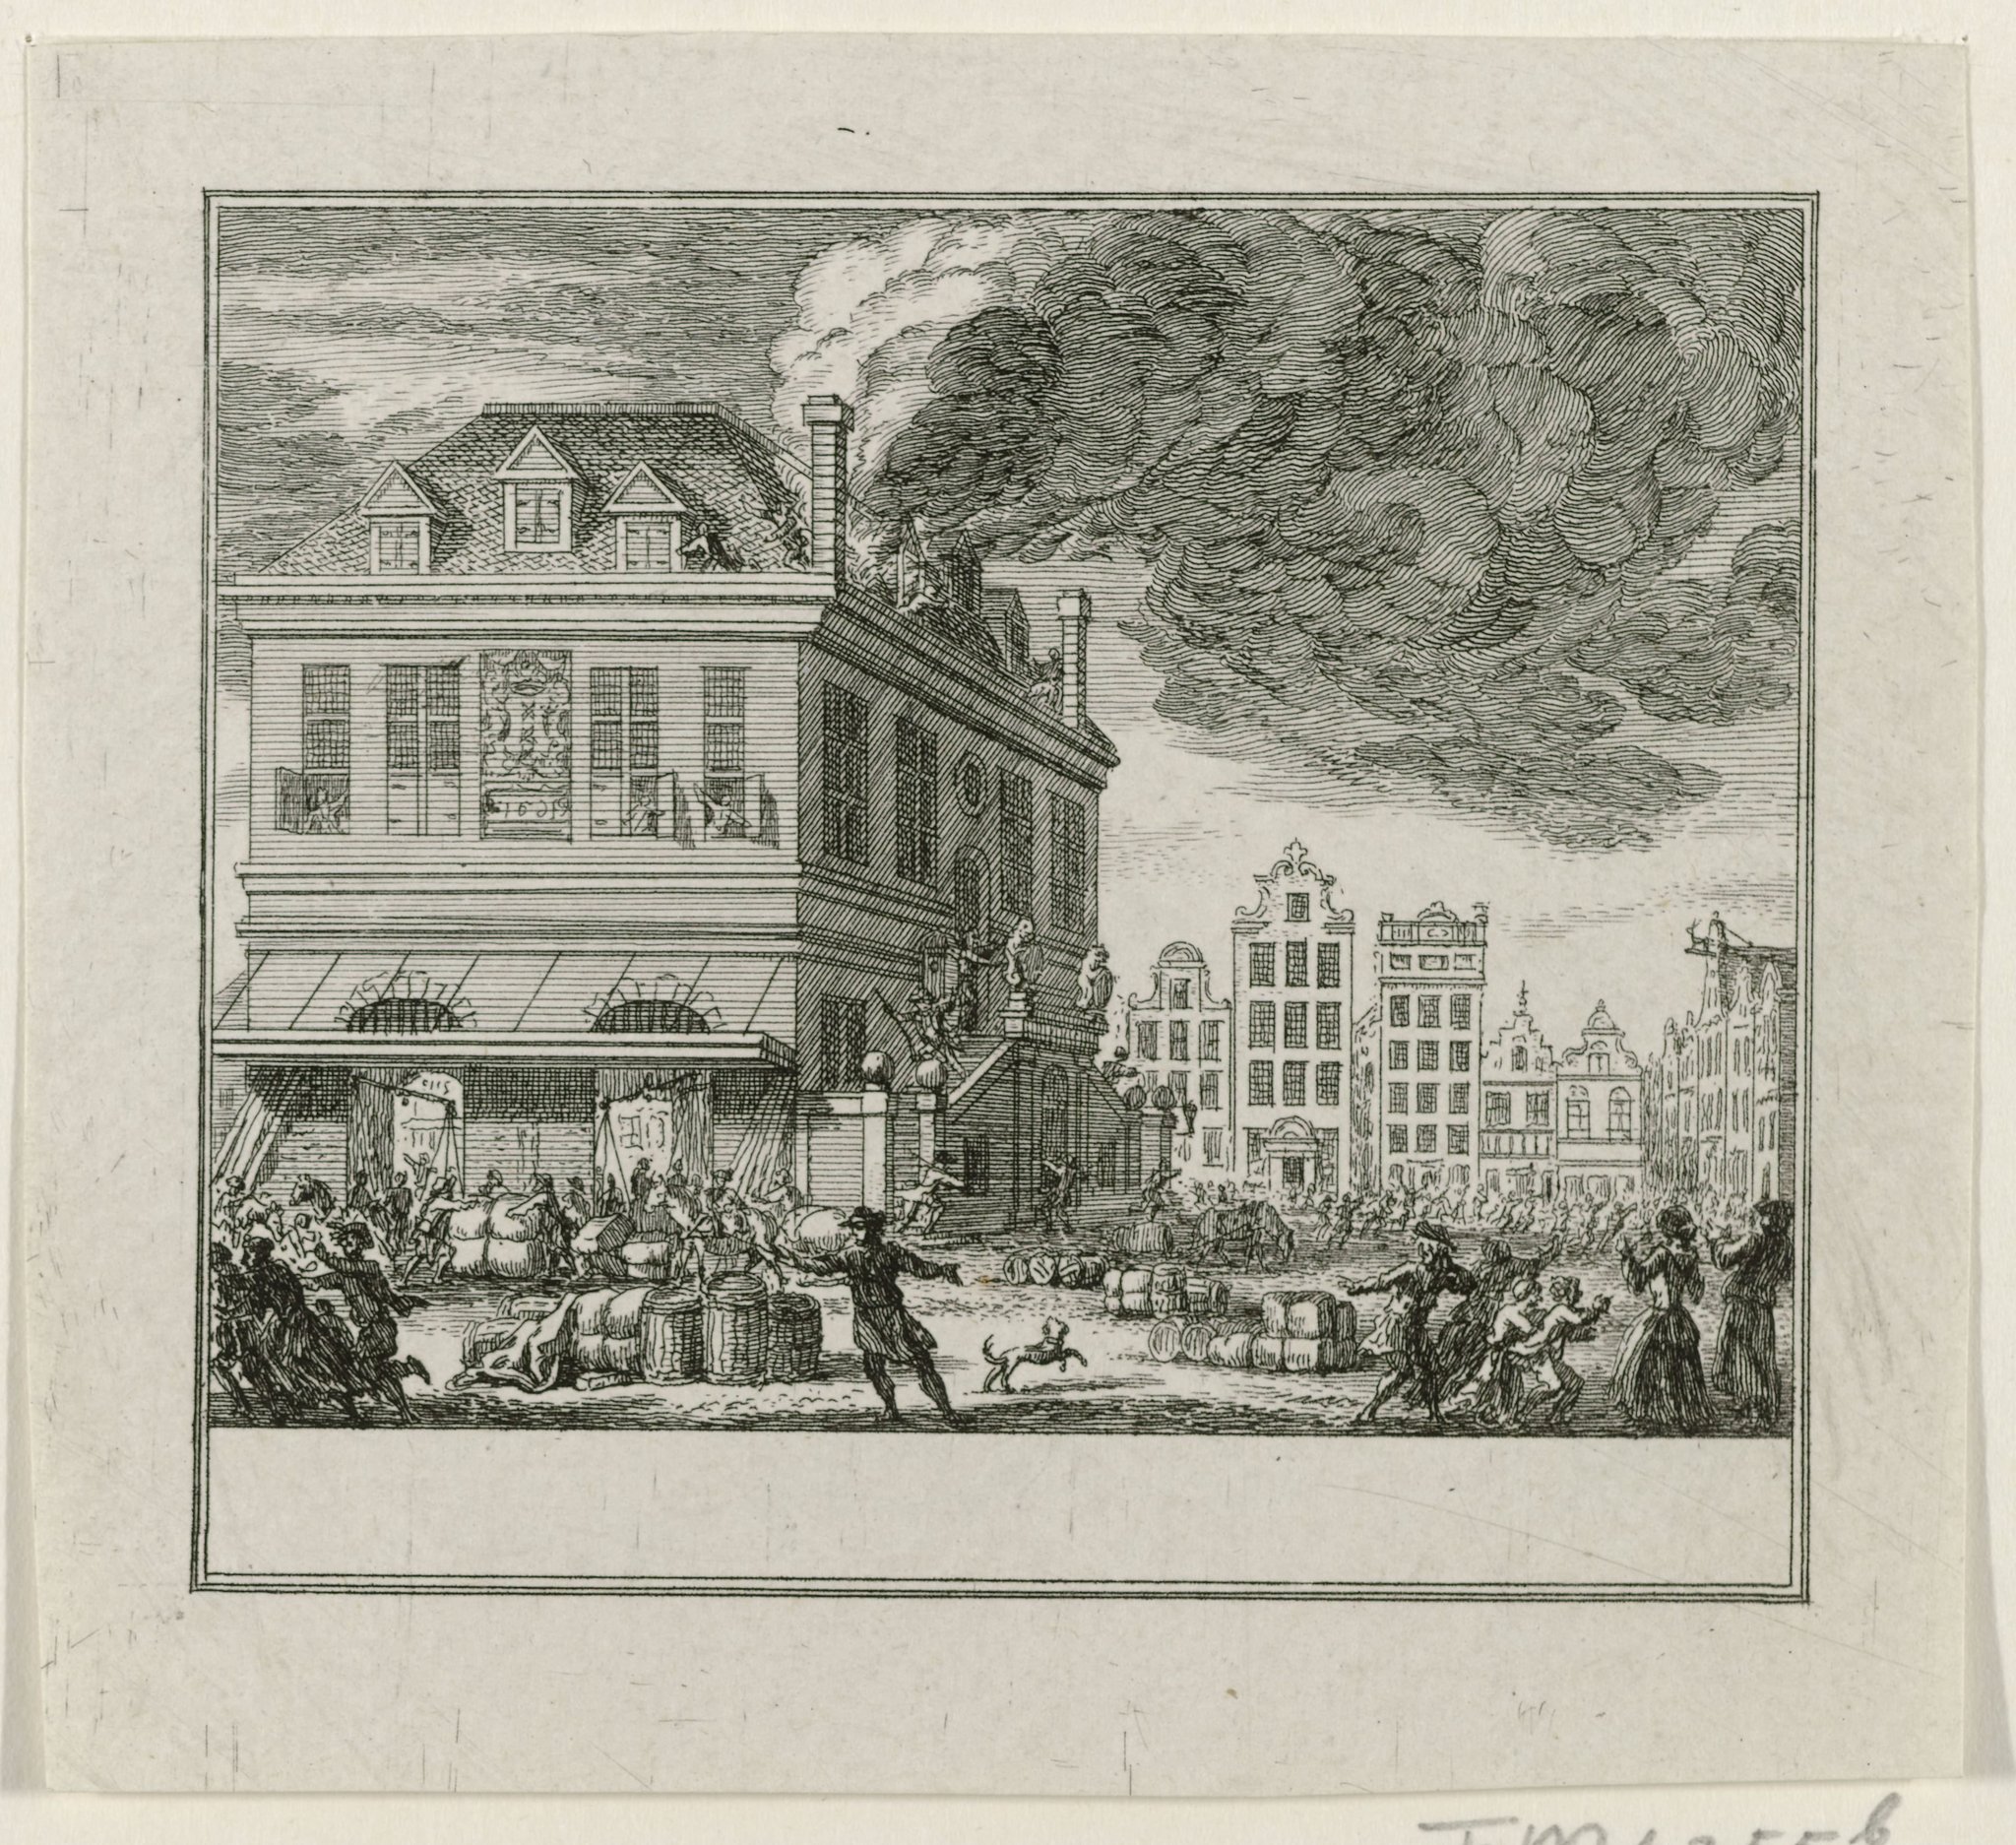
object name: history print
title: Brand in de Waag te Amsterdam, 1779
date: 1783-1784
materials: paper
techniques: etching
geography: northern netherlands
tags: on fire, ablaze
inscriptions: collector's mark: Lugt 2228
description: Gebruikt als illustratie in: Arend Fokke Simonsz. De vaderlandsche historie in themata. Amsterdam: Arend Fokke Simonsz., edities tussen 1783-ca. 1792.